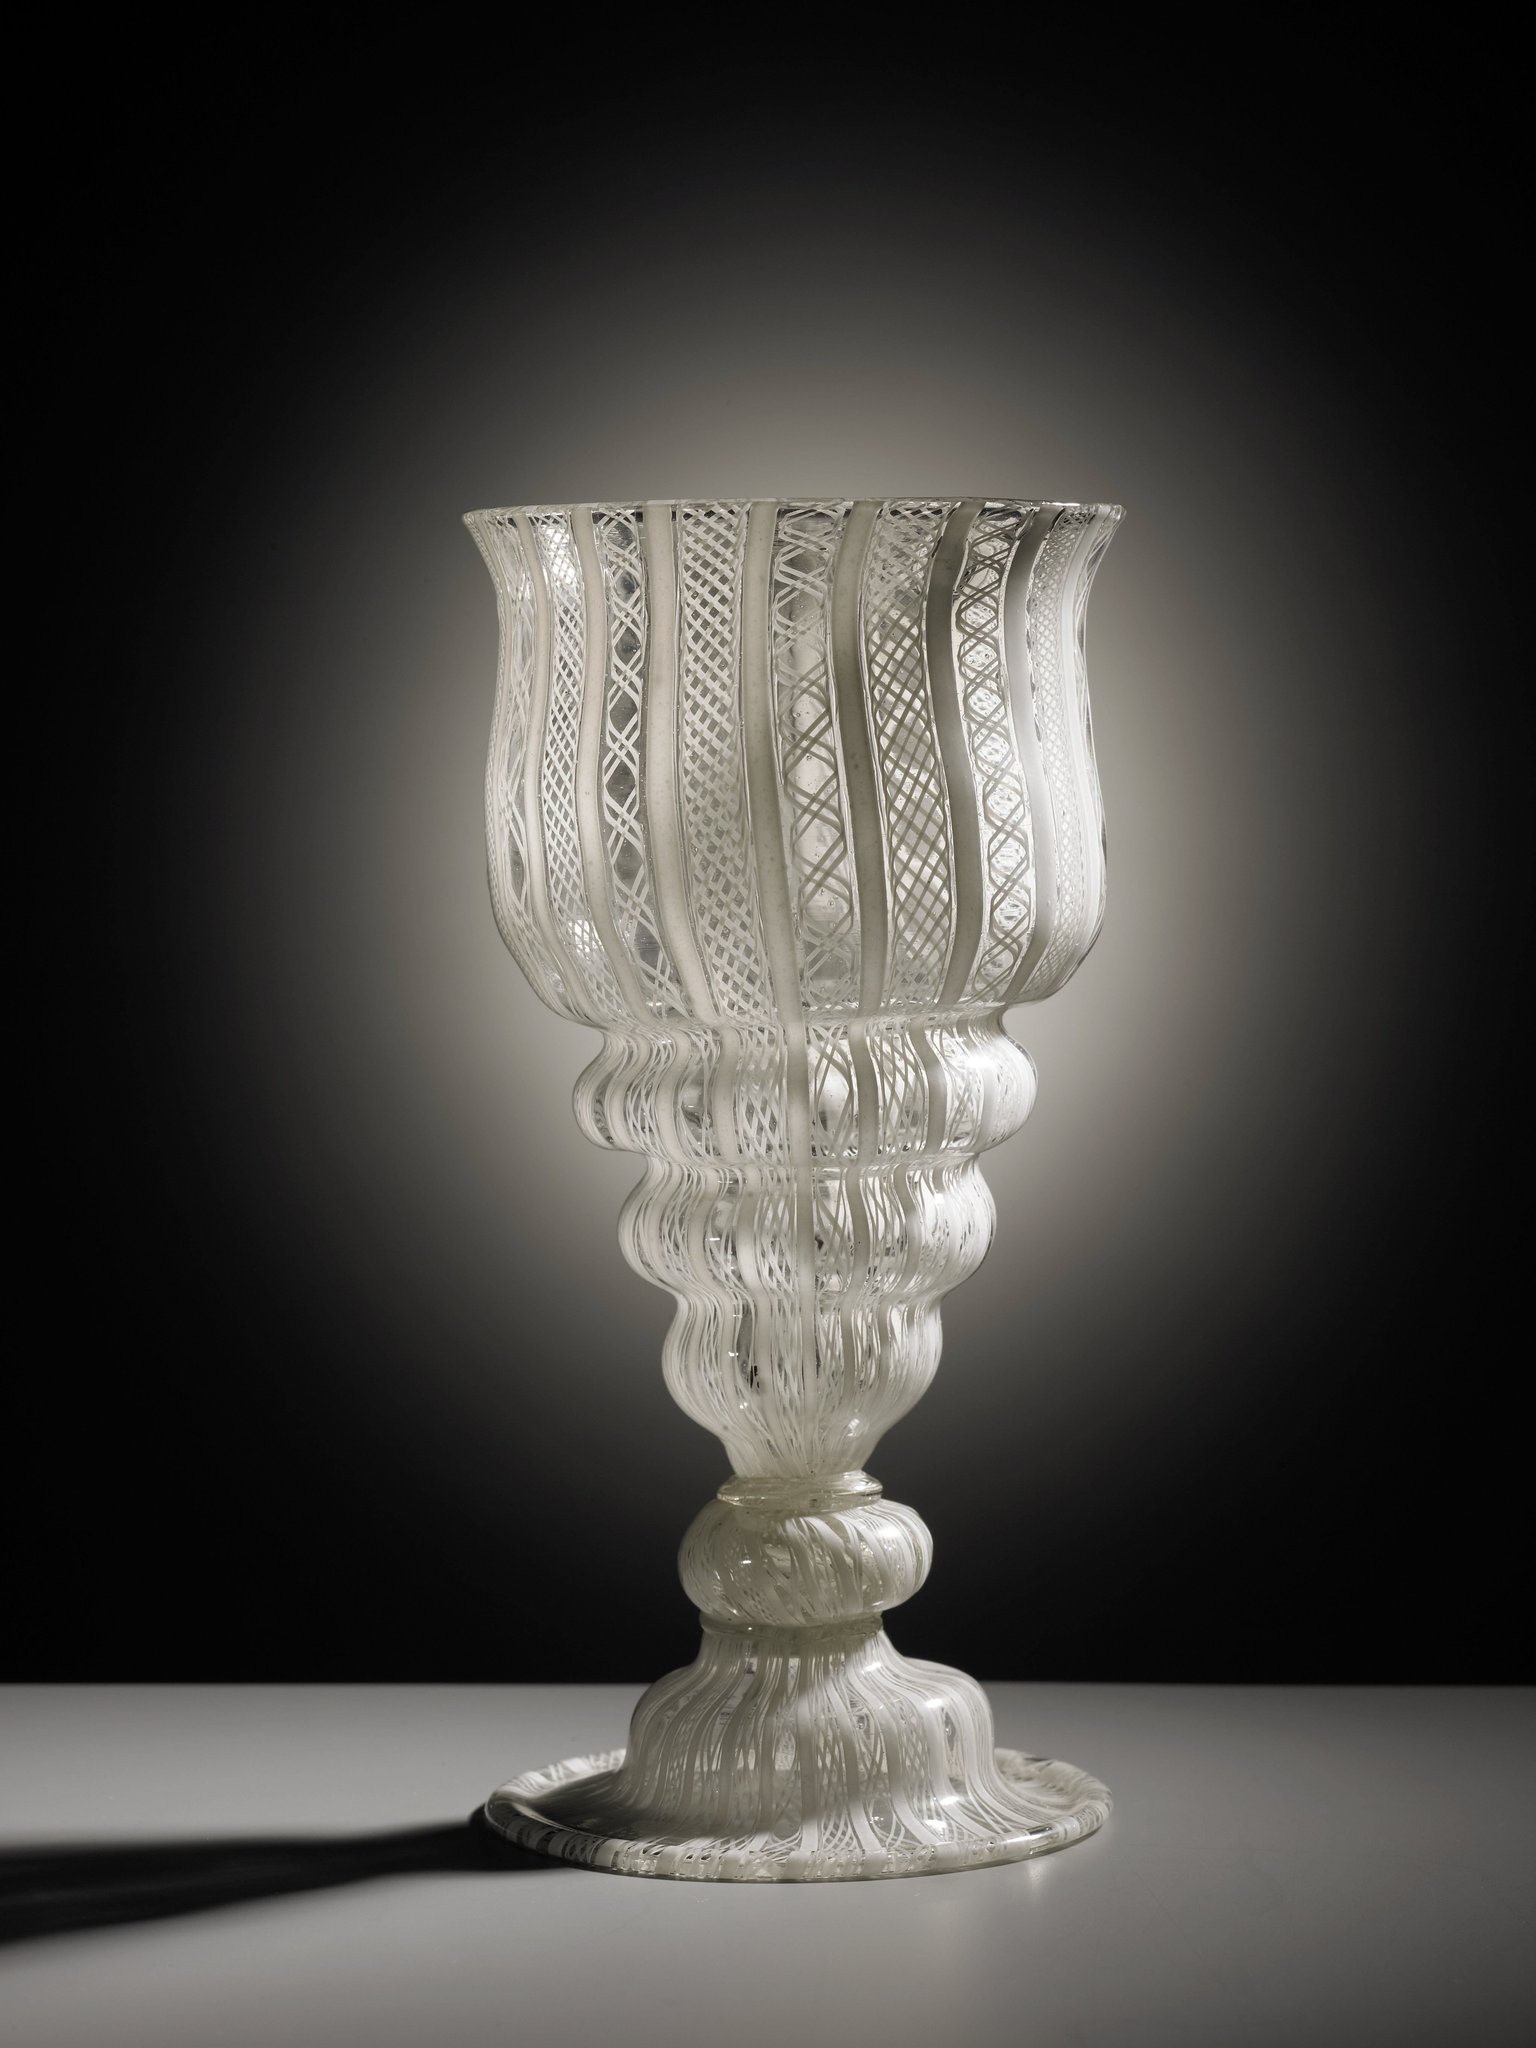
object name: goblet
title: Bokaal van filigraanglas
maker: Anonymous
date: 1590-1650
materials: glass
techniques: façon de venise, glassblowing, vetro a retorti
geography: low countries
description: Goblet, filigree glass. Netherlands or Germany, façon de Venise, c. 1600-1650. A.J. Enschedé bequest, 1896.